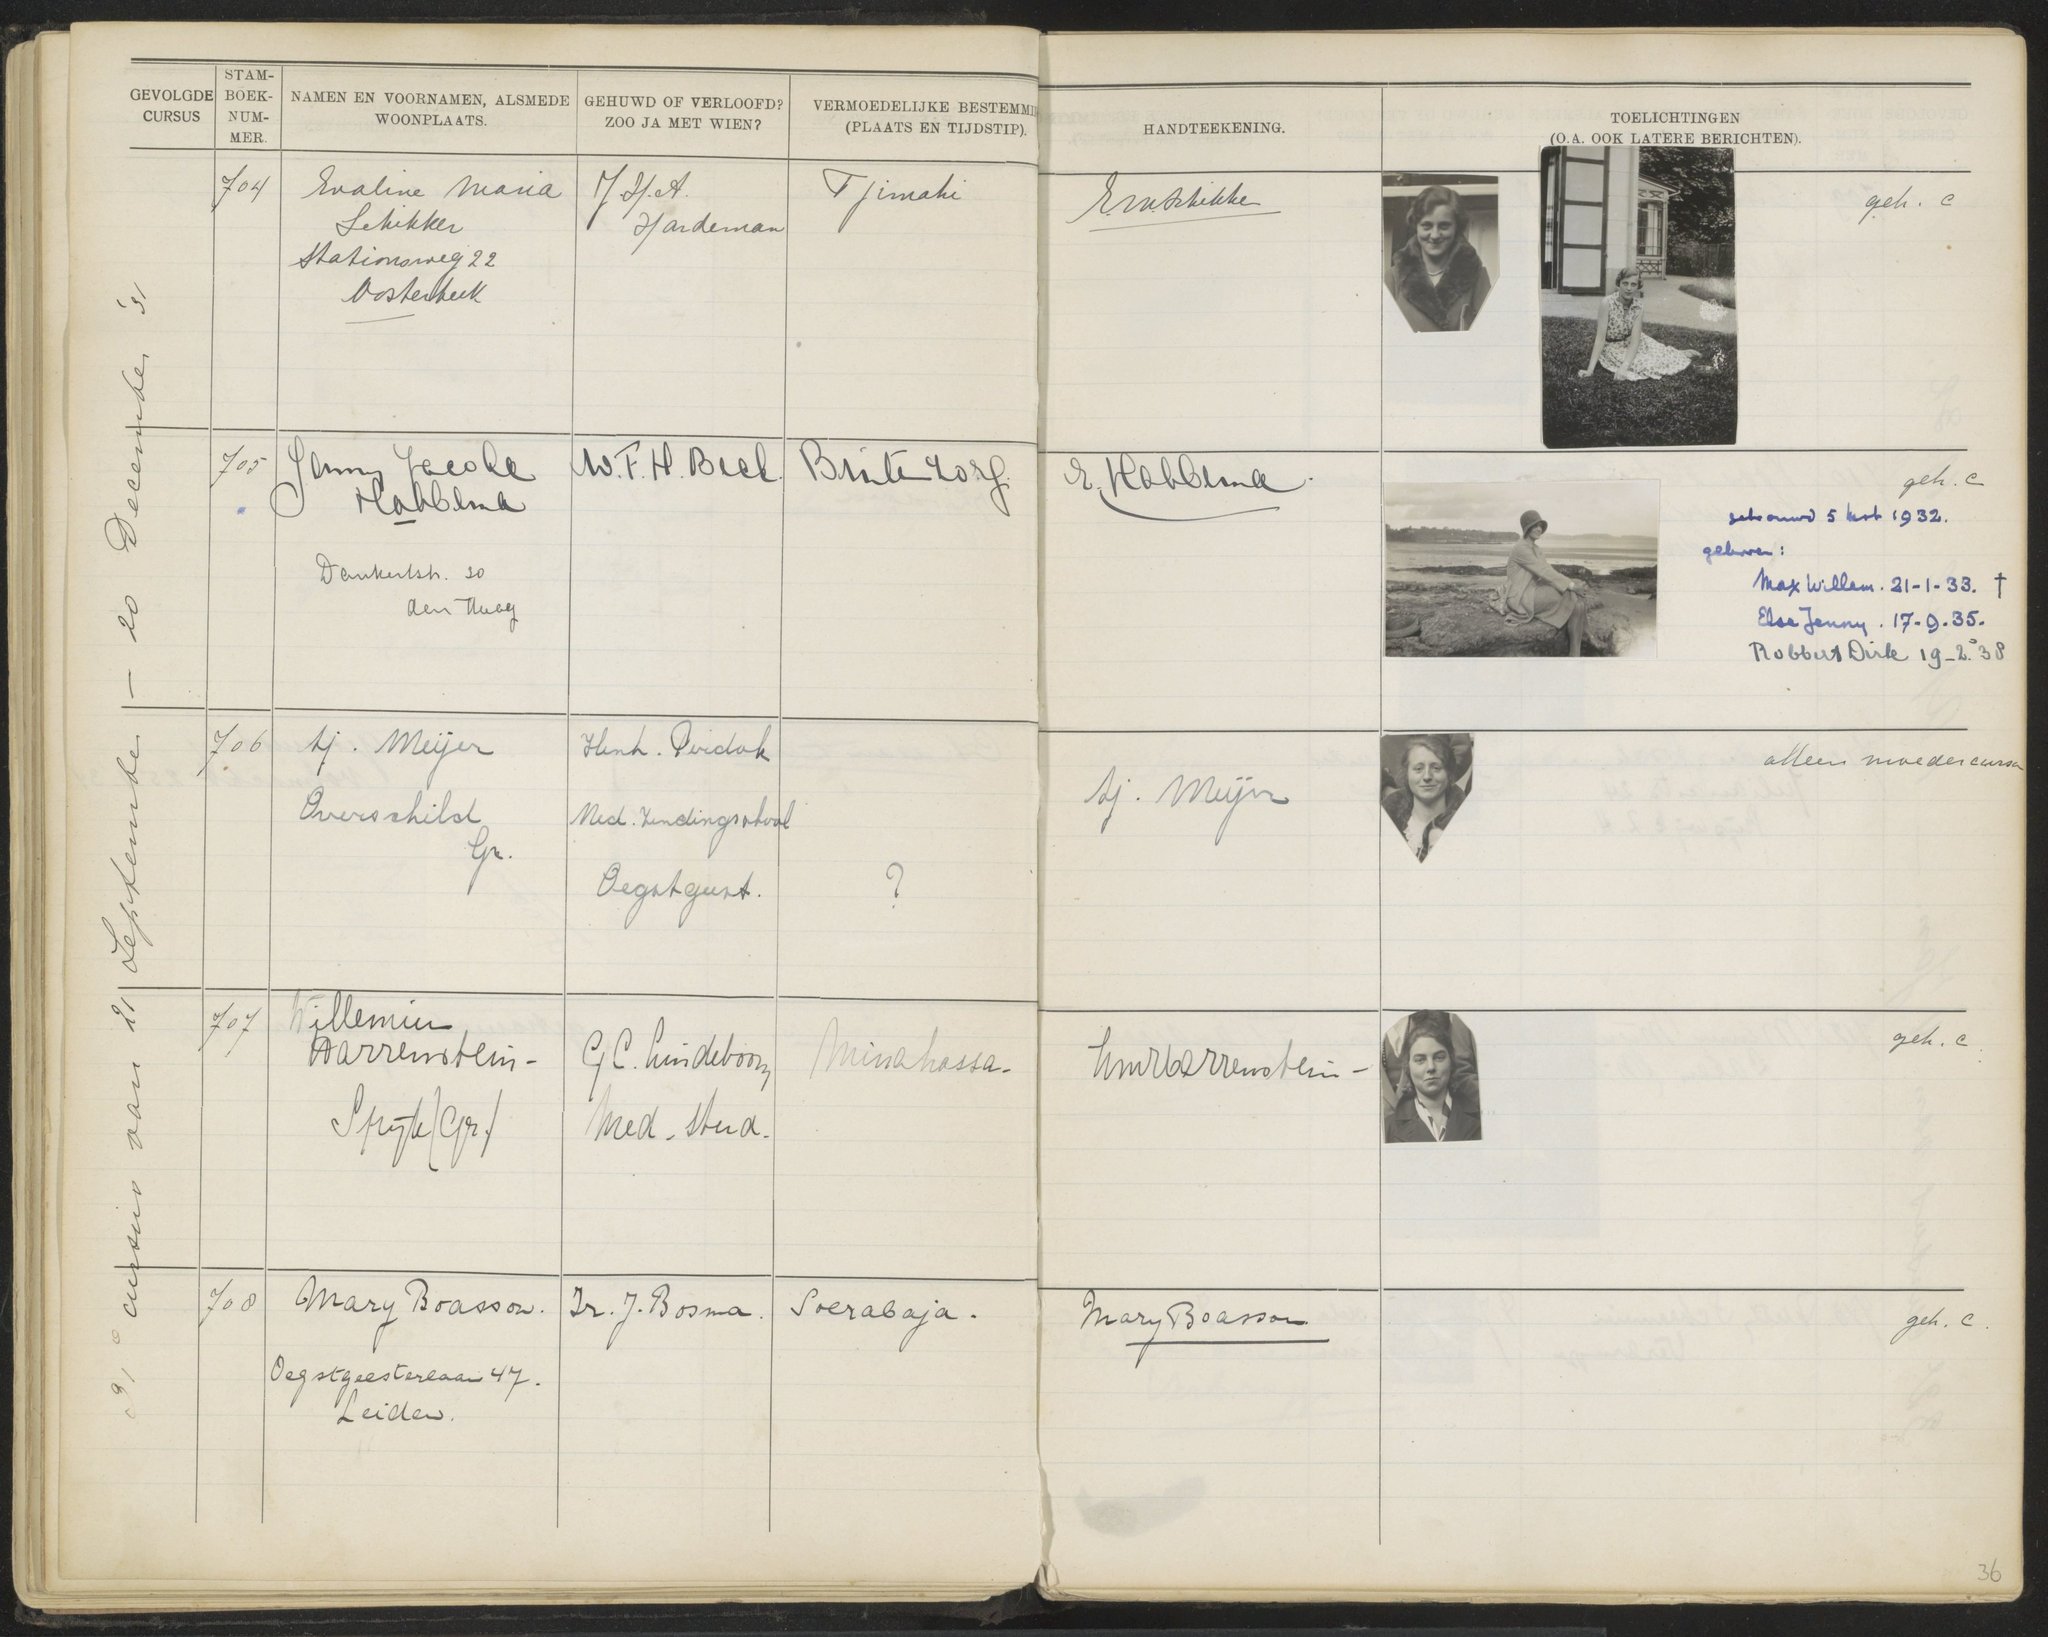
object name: photograph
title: Blad 36 uit Stamboek van de leerlingen der Koloniale School voor Meisjes en Vrouwen te 's-Gravenhage deel II (1930-1949)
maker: Anonymous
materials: paper, photographic support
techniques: photography, printing, writing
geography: the hague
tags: further education (+ pupil), further education, the hague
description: Twee pagina's met gegevens van de deelnemers aan de 31e driemaandelijkse cursus van 21 september tot en met 20 december 1931, stamboeknummers 704 tot en met 708. Onderdeel van Stamboek van de leerlingen der Koloniale School voor Meisjes en Vrouwen te 's-Gravenhage deel II (1930-1949).